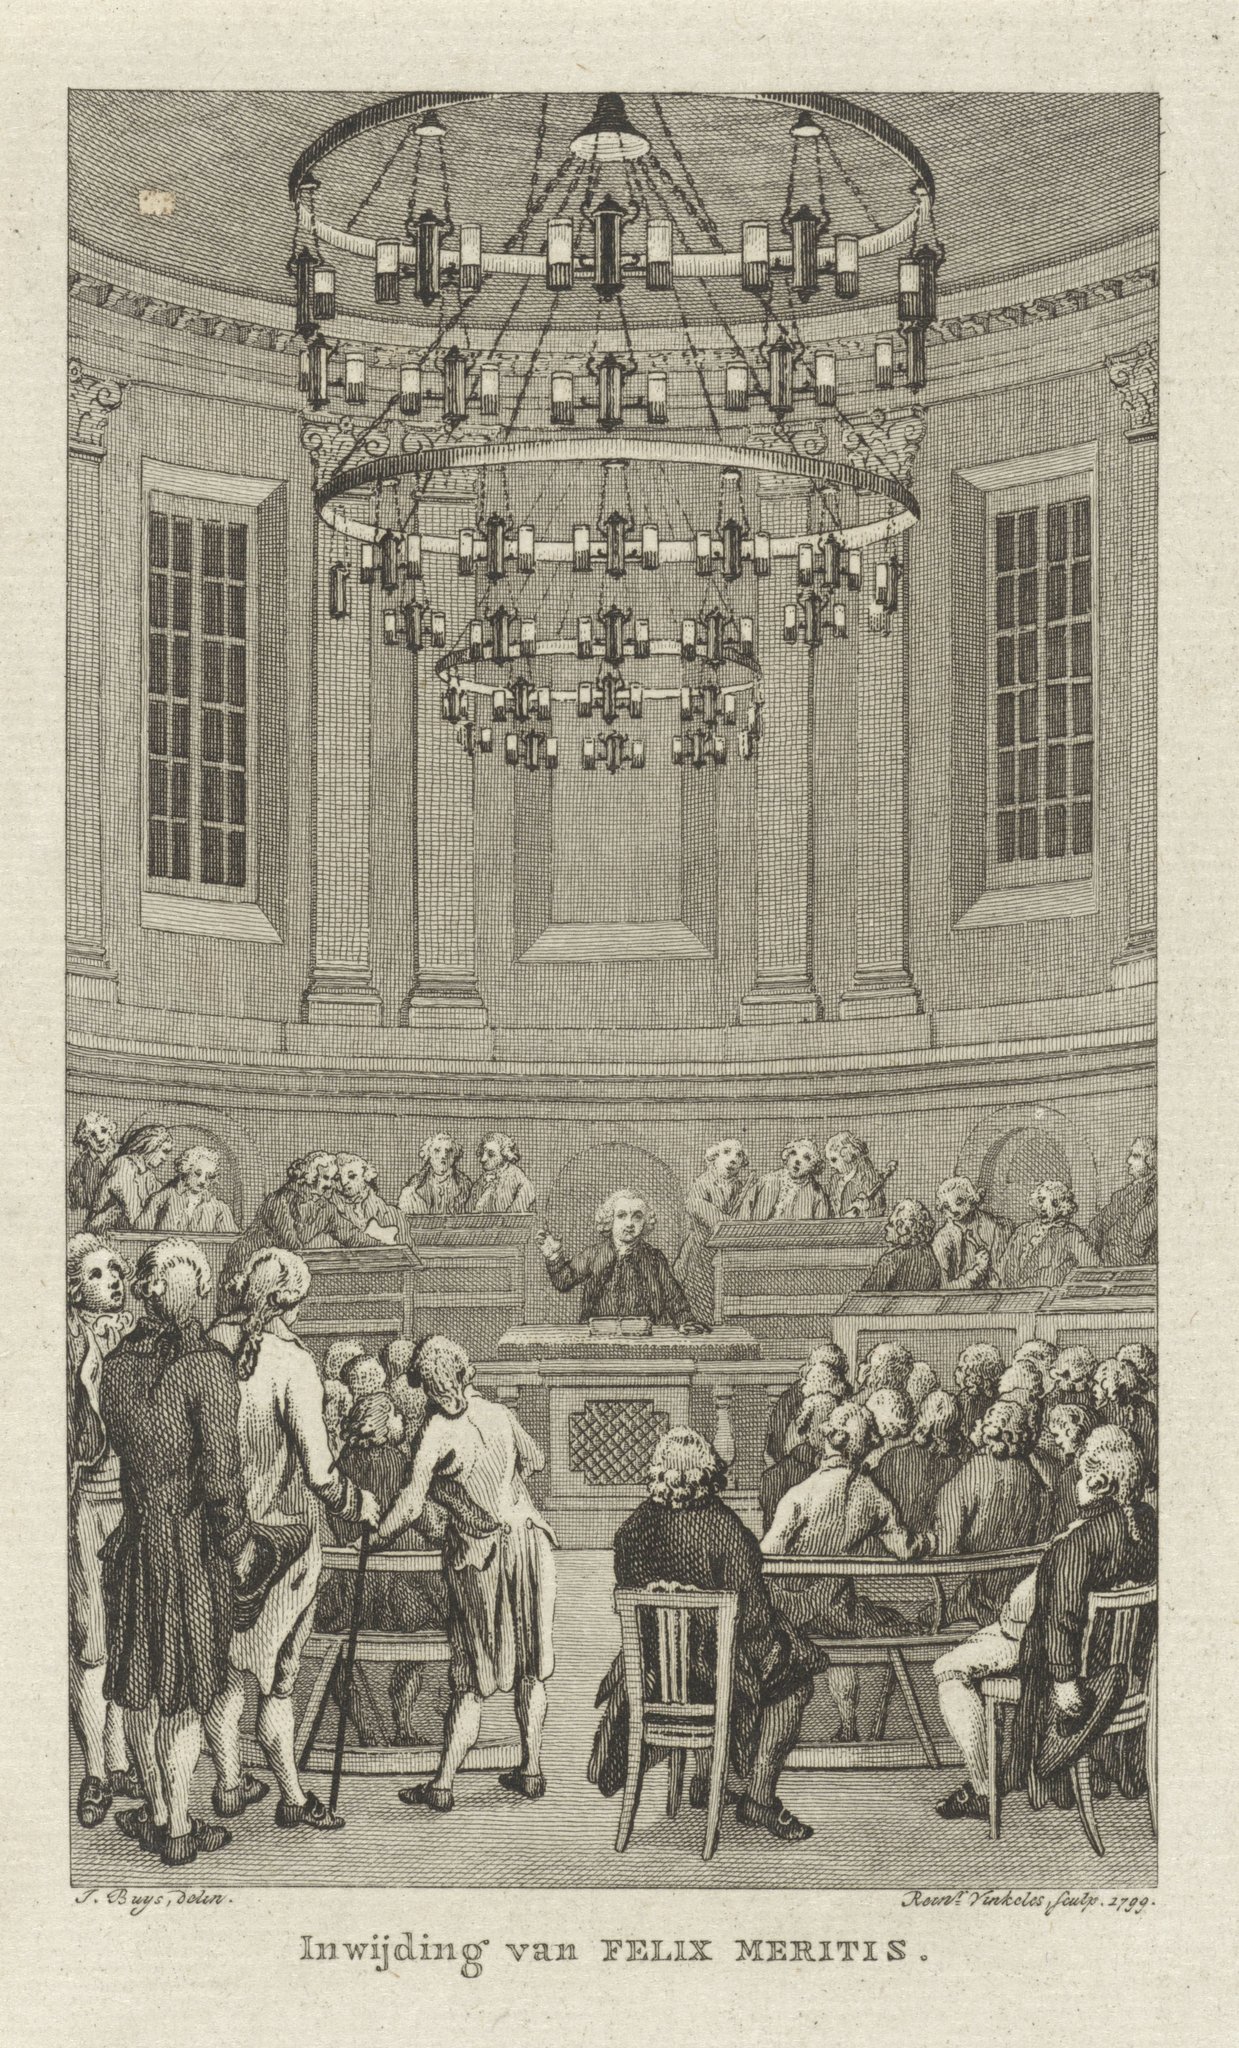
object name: print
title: Inwijding van Felix Meritis, 1788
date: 1799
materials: paper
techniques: engraving, etching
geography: amsterdam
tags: the hague, amsterdam, physicist, jean henri van swinden, address, talk, lecture (~ meeting), learned society, academy of sciences, concert hall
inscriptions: collector's mark: Lugt 2233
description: Gebruikt als illustratie in: P.A. Loosjes. Vaderlandsche historie, vervattende de geschiedenissen, der Vereenigde Nederlanden (...). Ten onmiddelyken vervolge van Wagenaar's Vaderlandsche historie. Amsterdam: Johannes Allart, dl. 23 (1799), p. 44-45.